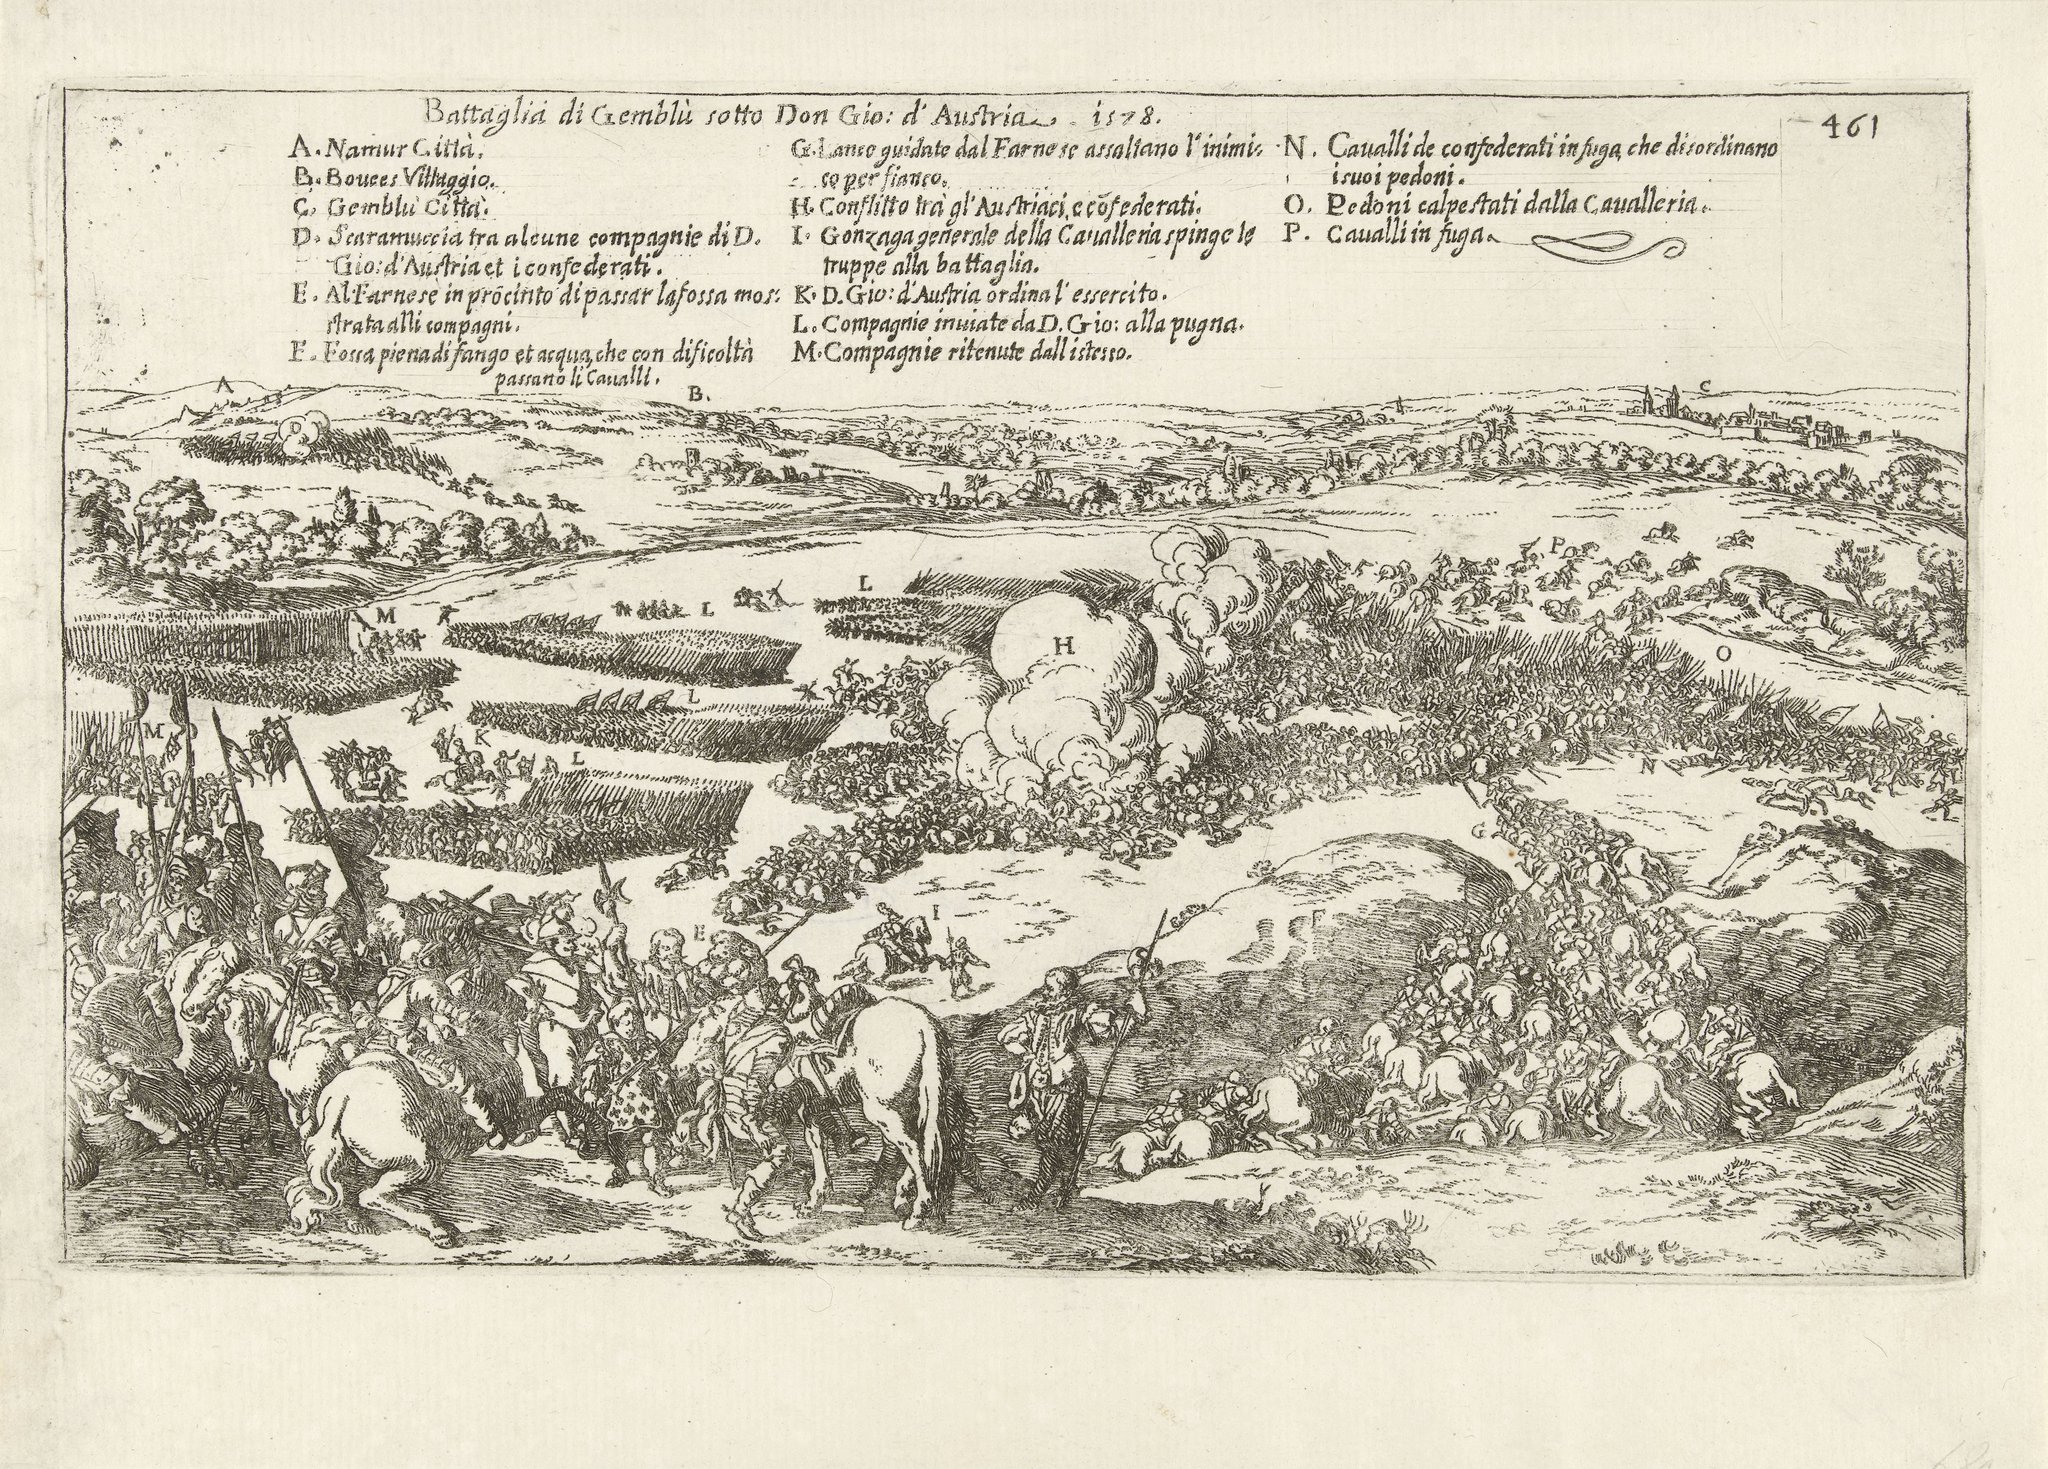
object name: history print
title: Battaglia di gemblu sotto Don Gio: d'Austria, 1578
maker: Anonymous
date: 1630-1699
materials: paper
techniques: etching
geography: italy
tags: battle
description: Slag bij Gembloers, 31 januari 1578. Veldslag waarbij het Staatse leger verslagen wordt door het leger van Farnese. In de verte de steden Namen en Gembloux. Bovenaan de legenda A-P in het Italiaans.